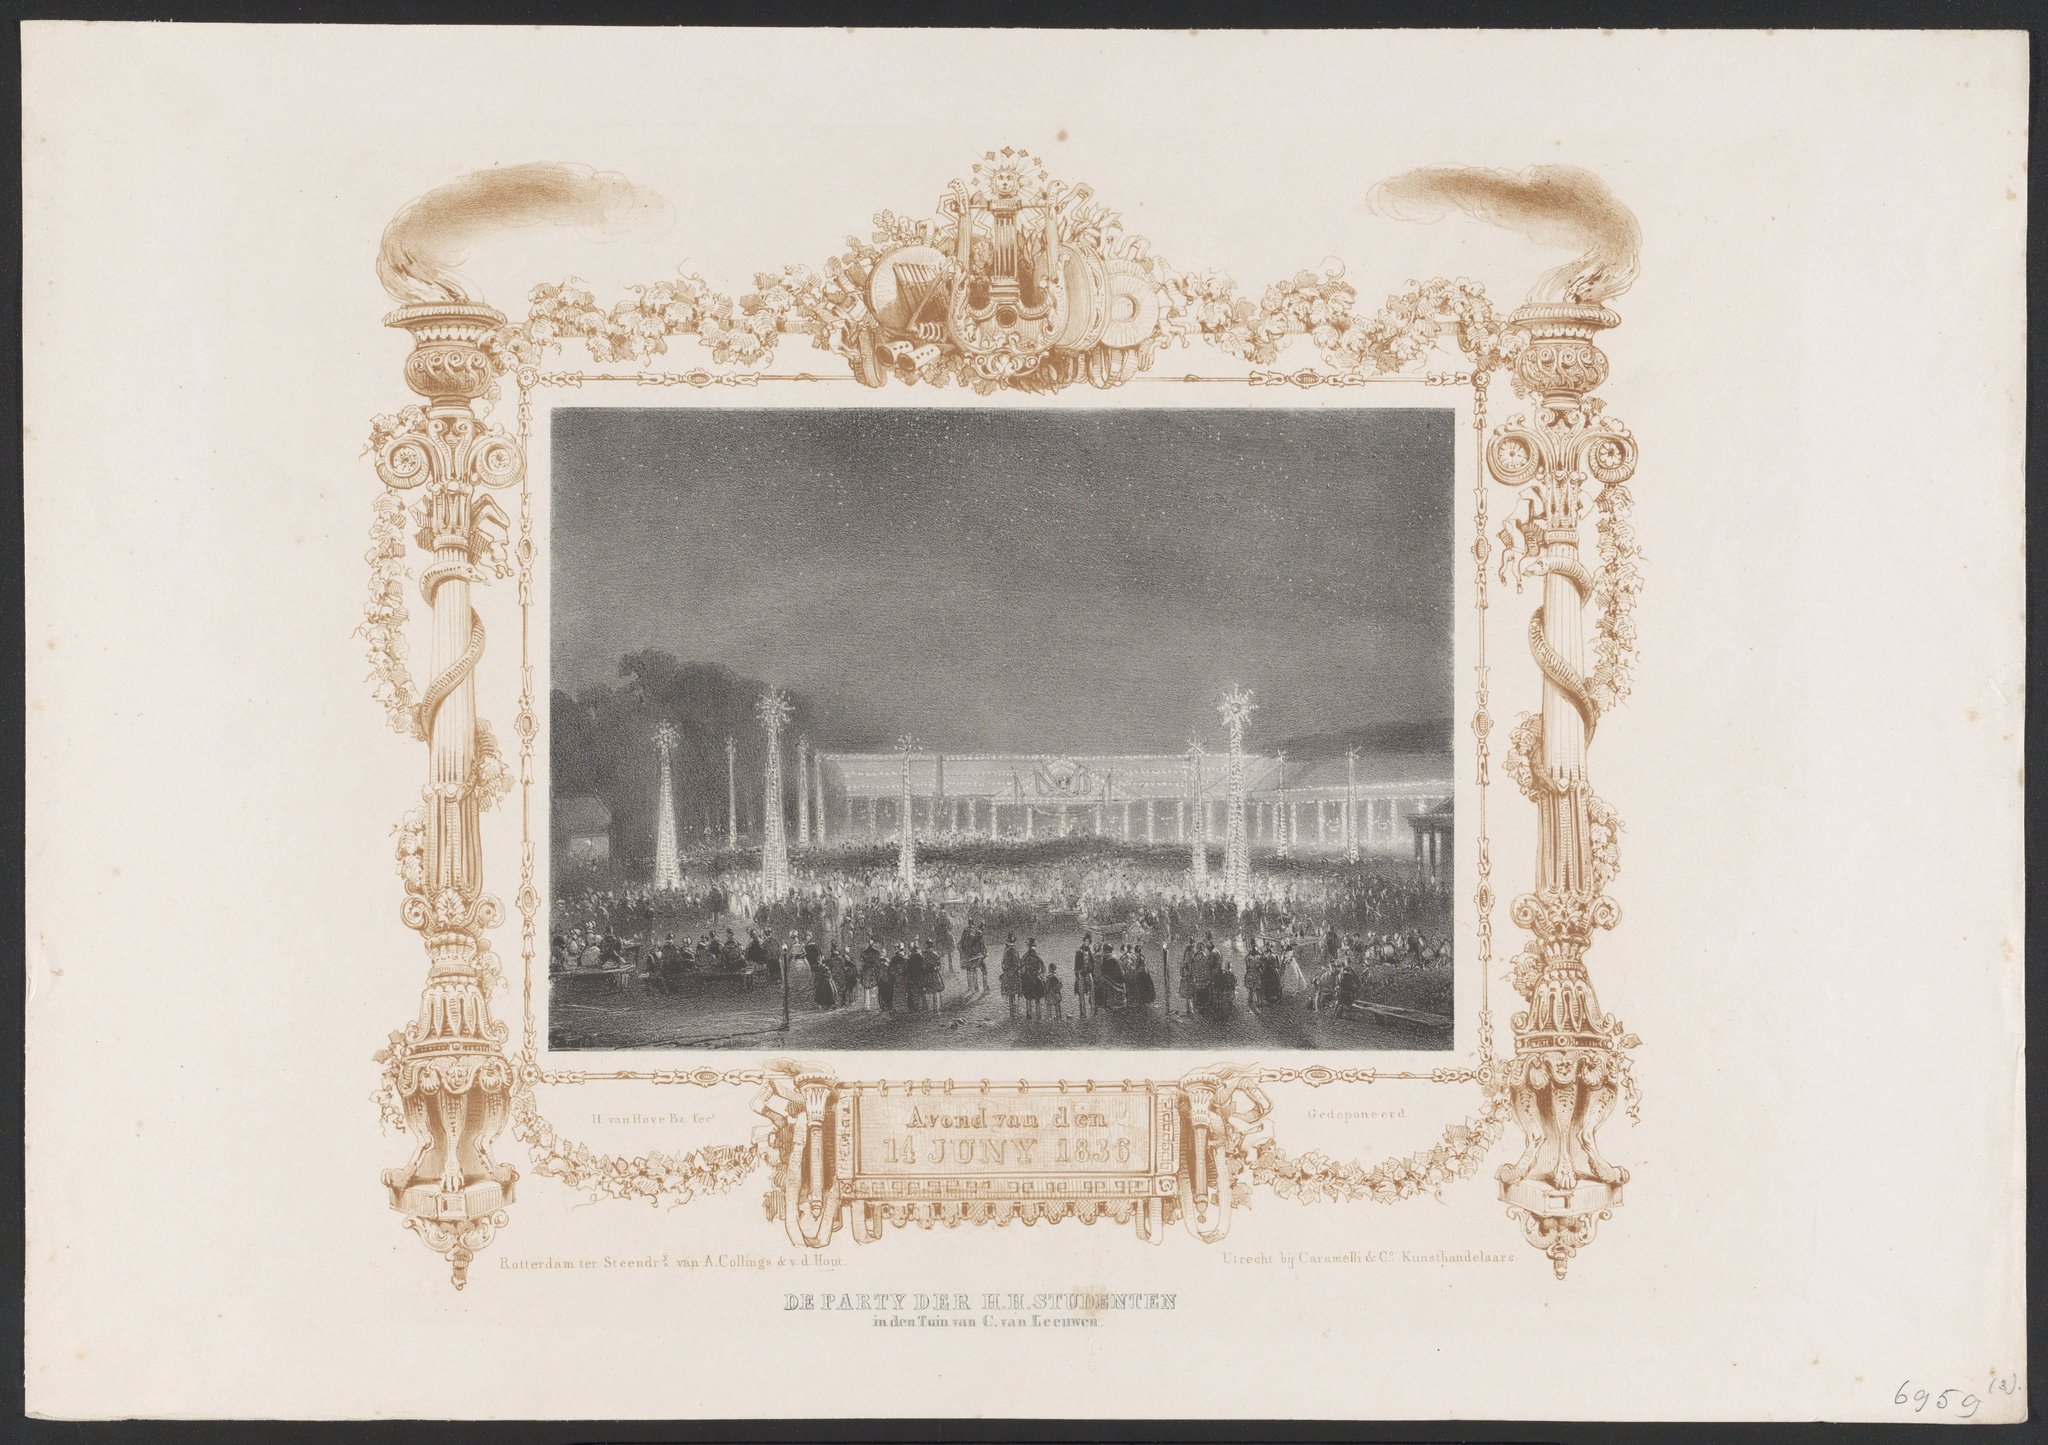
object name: print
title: Platen van de viering van het tweede eeuwfeest van de Utrechtsche Hogeschool, 1836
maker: huib van hove bz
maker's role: painter, print maker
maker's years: 1814-1867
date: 1836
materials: paper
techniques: lithograph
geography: rotterdam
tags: party (students), commemoration of the founding of a university, student life, utrecht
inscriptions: : ‘Gedeponeerd’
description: Groots feest voor de studenten van de Hogeschool, 's avonds gehouden in de verlichte tuin van Cornelis van Leeuwen, 14 juni 1836. Binnen een gekleurde ornamentele kader met zuilen met brandende vuurpotten. Onderdeel van de serie van zes ongenummerde platen van de feestelijkheden bij de viering van het tweede eeuwfeest (1636-1836) van de Utrechtsche Hogeschool, 12-17 juni 1836.